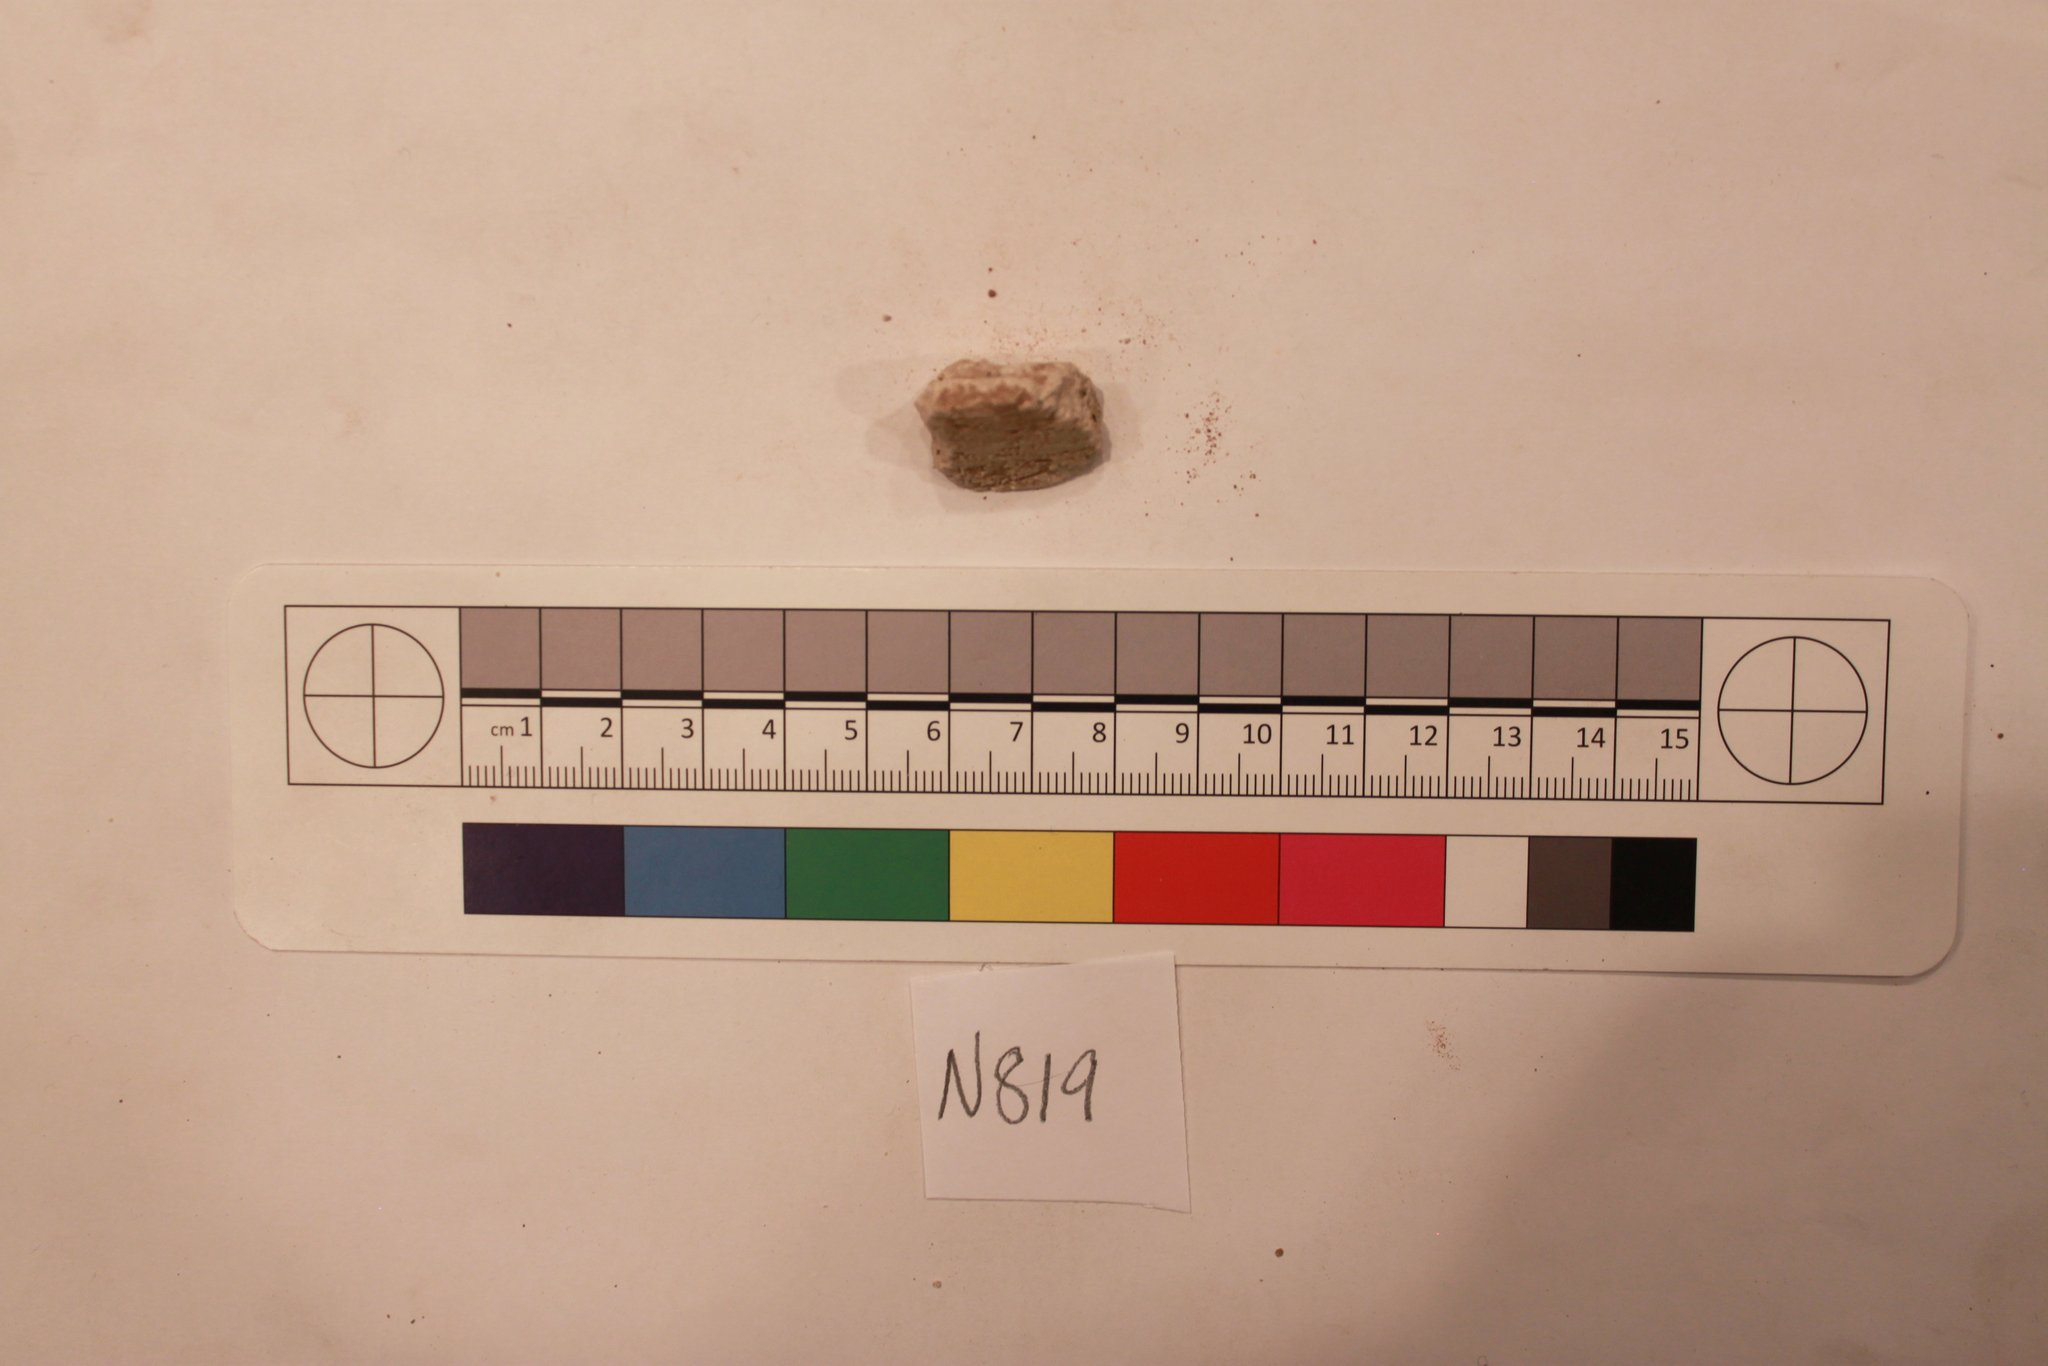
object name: fragment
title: Stucco Fragment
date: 701-1200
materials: plaster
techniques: carving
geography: iran